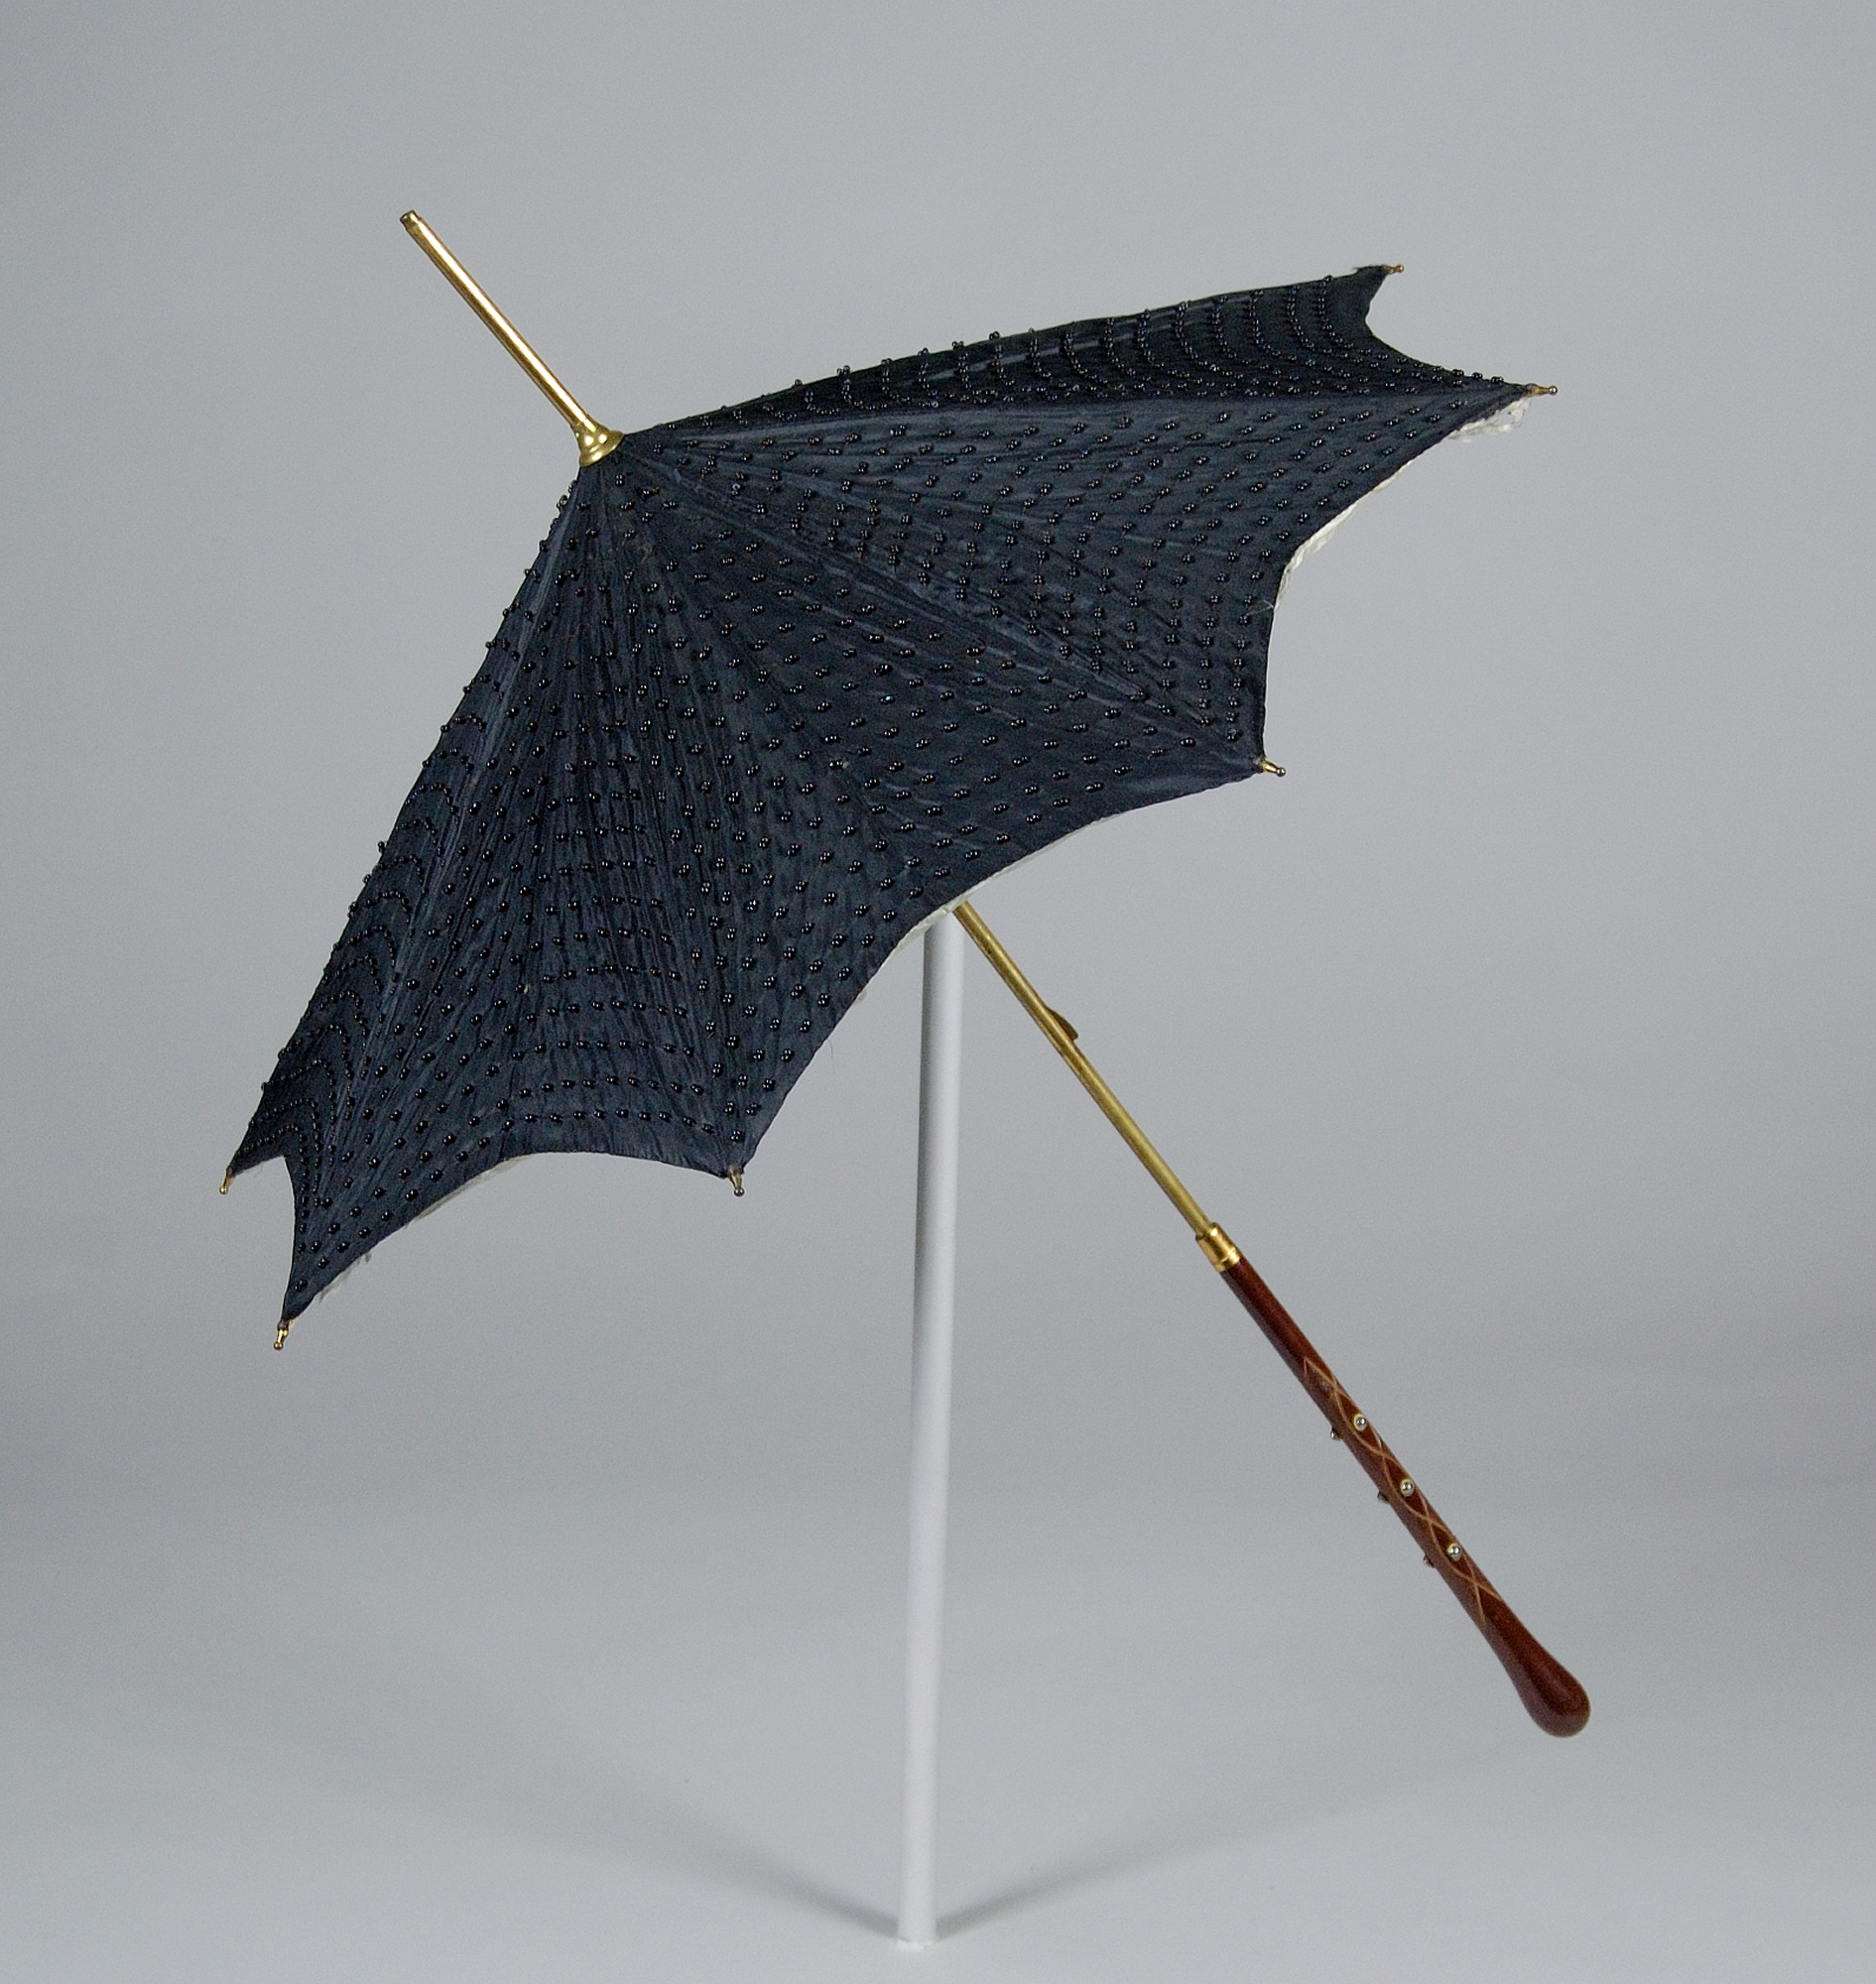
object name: parasol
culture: french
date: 1860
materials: glass, metal, silk, wood